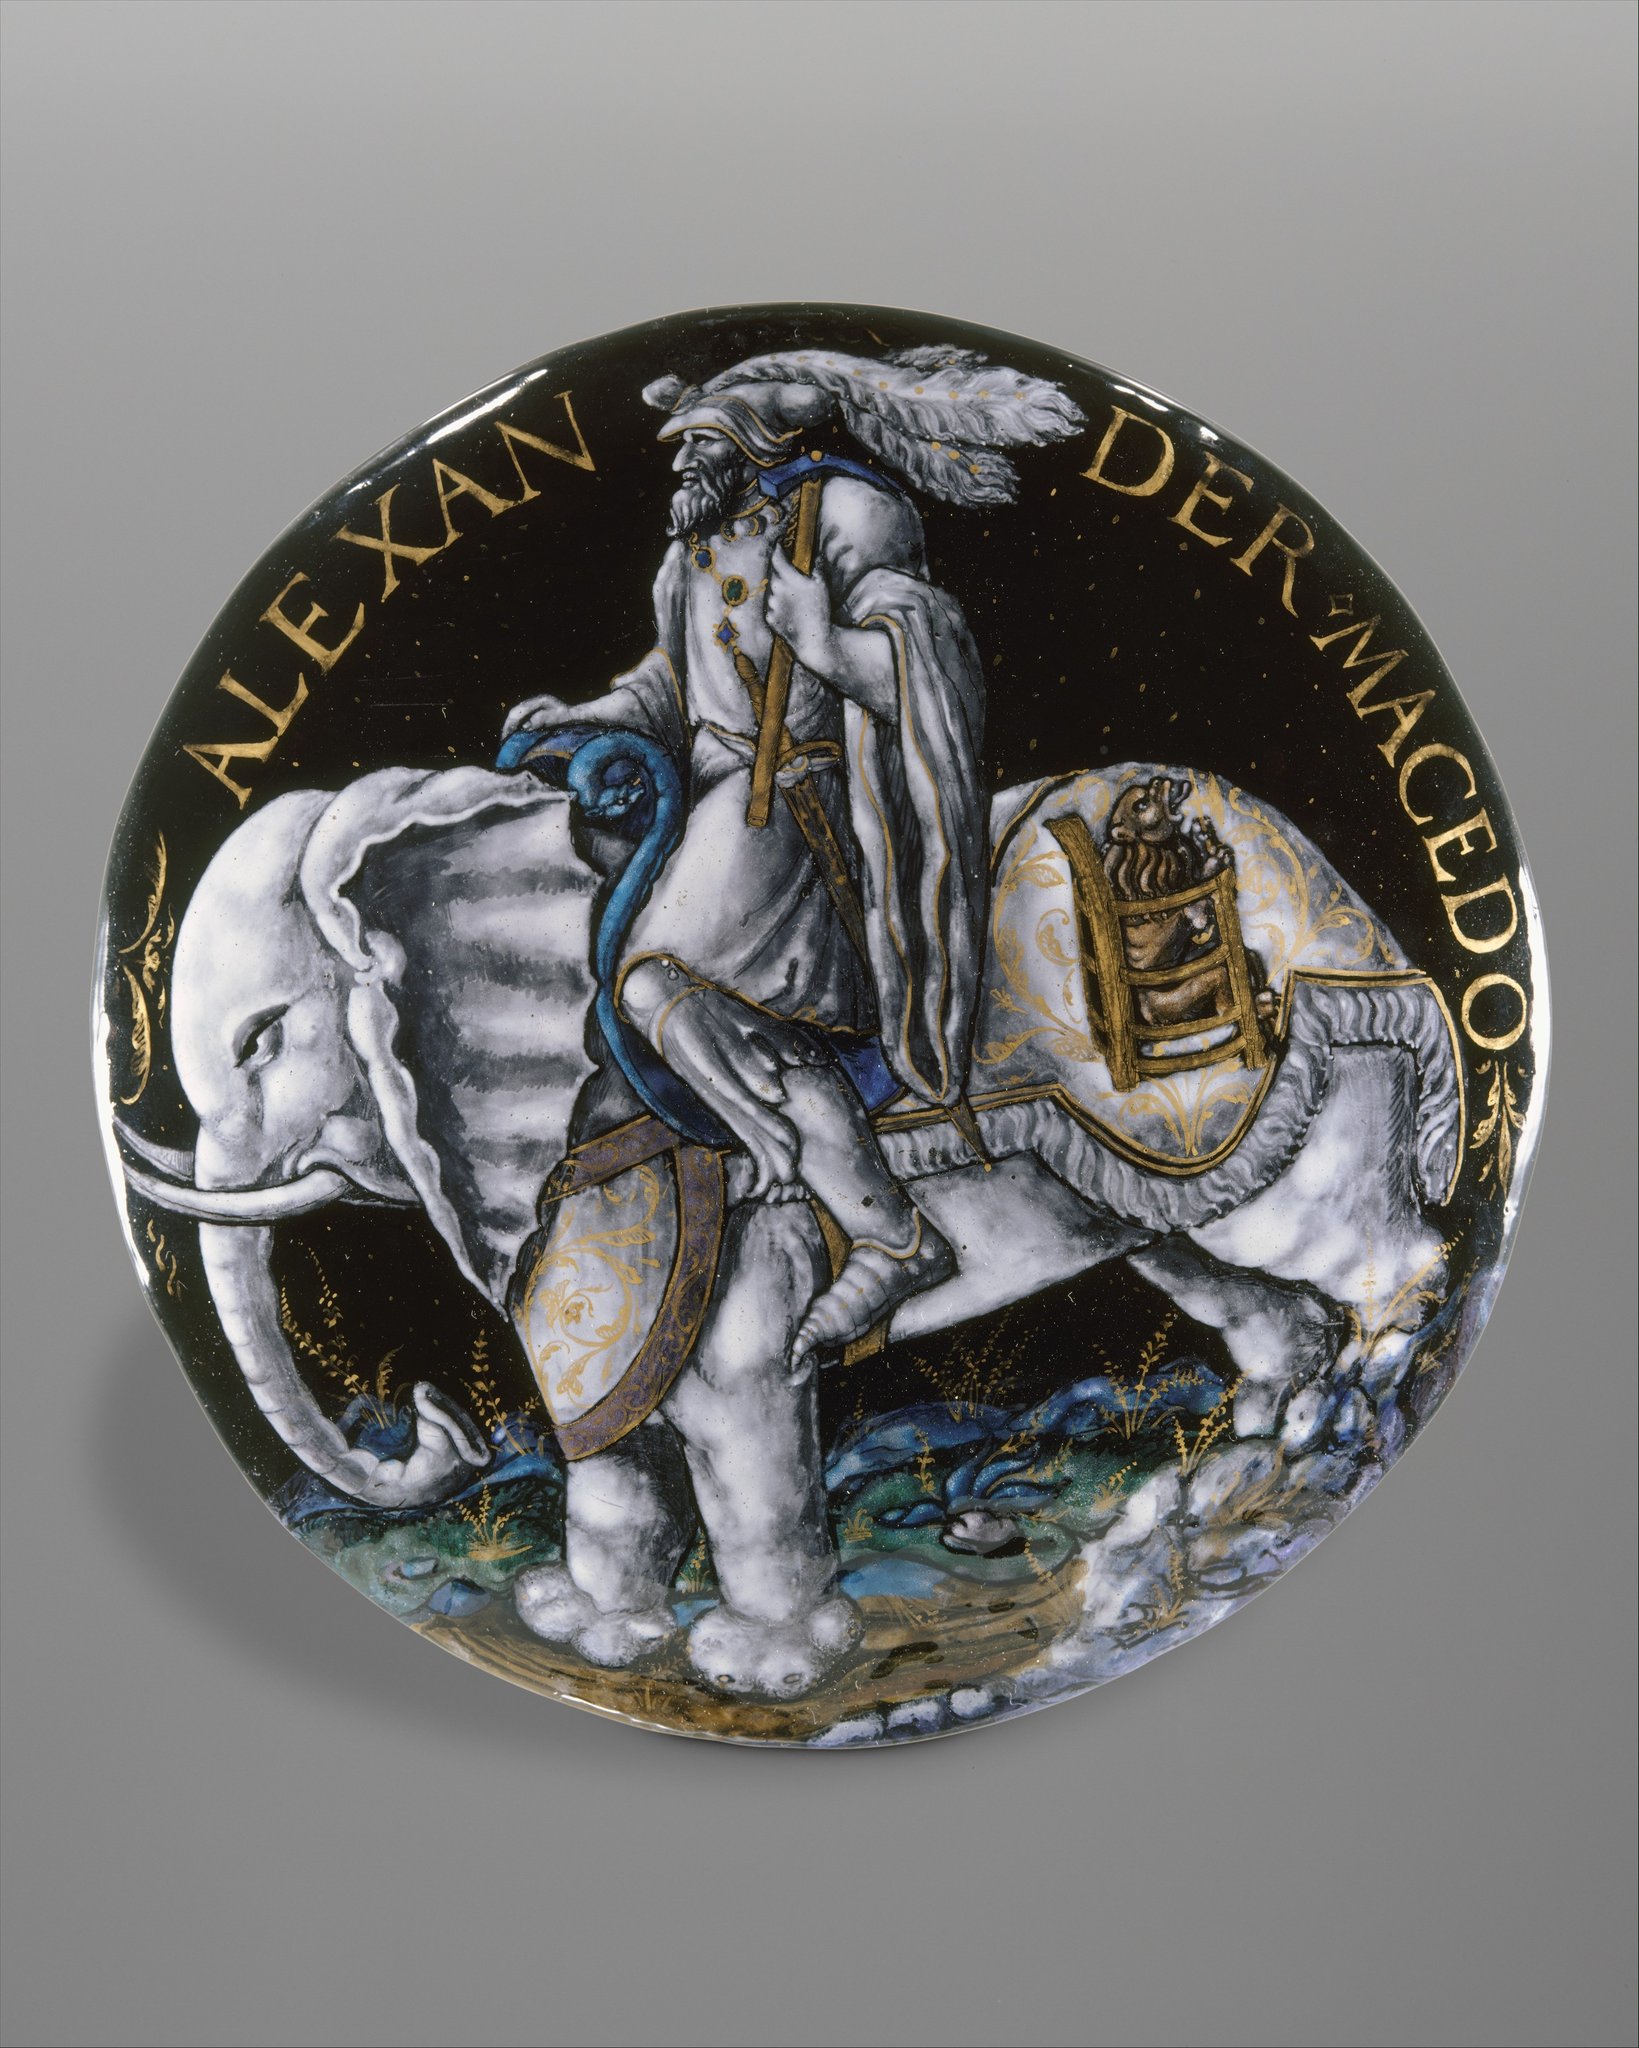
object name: medallion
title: Alexander the Great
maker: colin nouailher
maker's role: enameler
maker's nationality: french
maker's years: 1471-1571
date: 1541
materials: copper, enamel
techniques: gilding, painting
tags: alexander the great,elephants